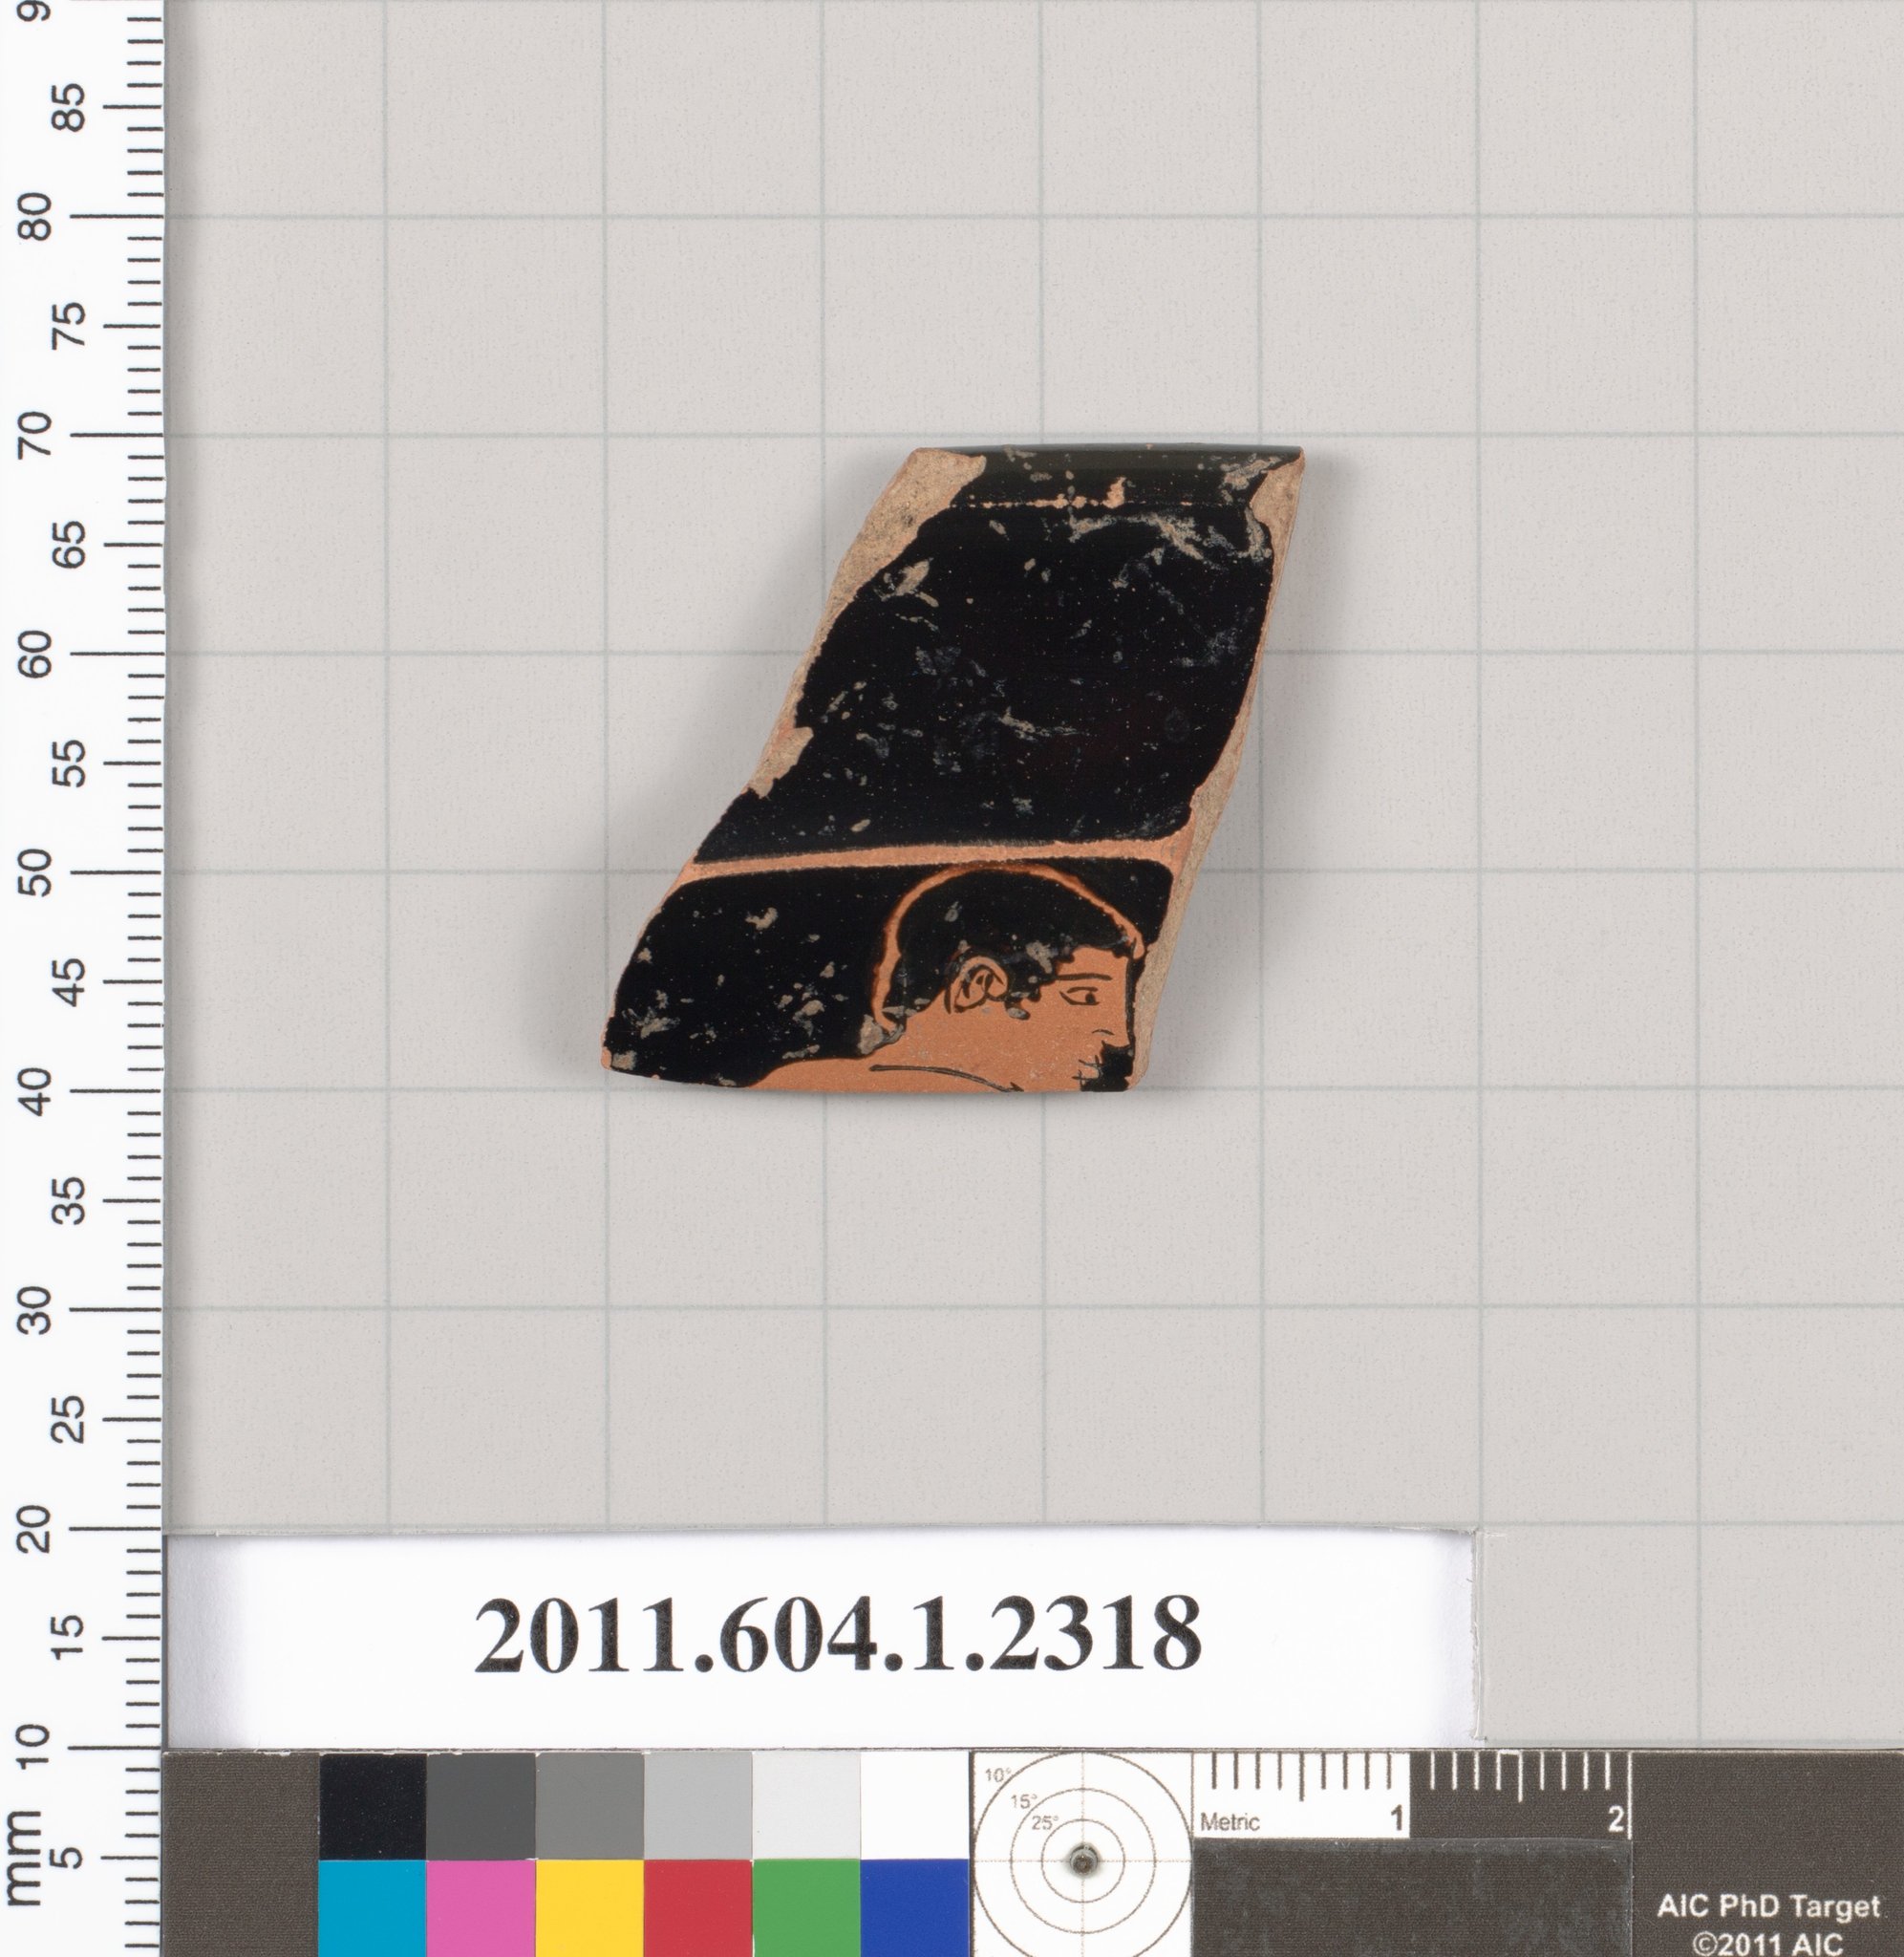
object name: kylix fragment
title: Terracotta rim fragment of a kylix (drinking cup)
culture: greek, attic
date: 475-451 BCE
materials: terracotta